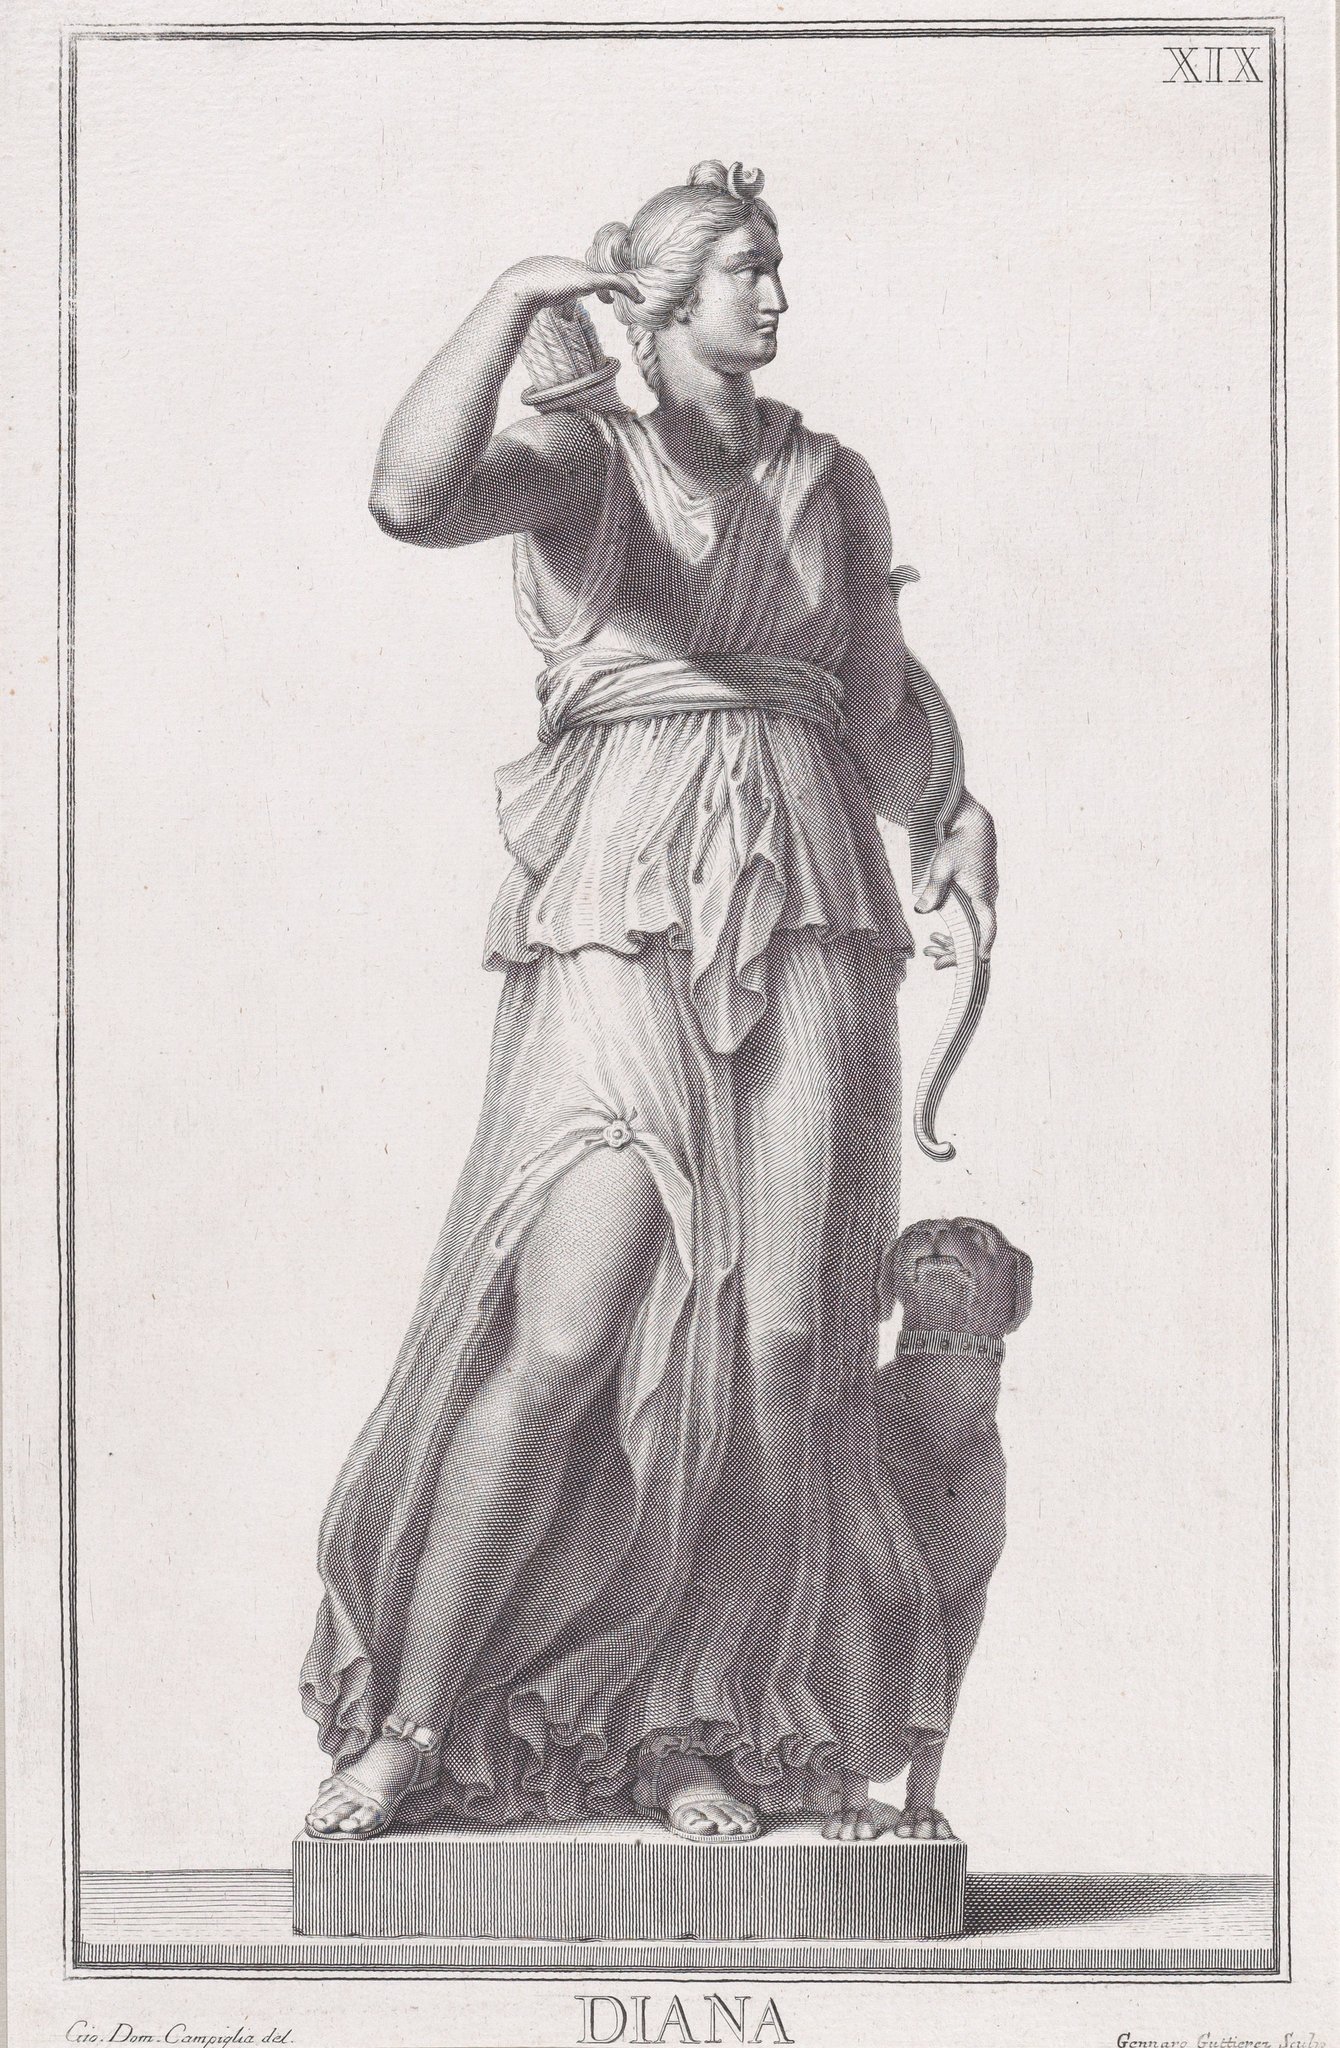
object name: print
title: Plate XIX (19): Diana, from "Museum Florentinum" (Statuae antiquae dorum et virorum illustrium)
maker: genaro gutiérrez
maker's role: artist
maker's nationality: spanish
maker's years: 1788-1798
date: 1734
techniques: engraving, etching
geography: florence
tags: women,diana,dogs